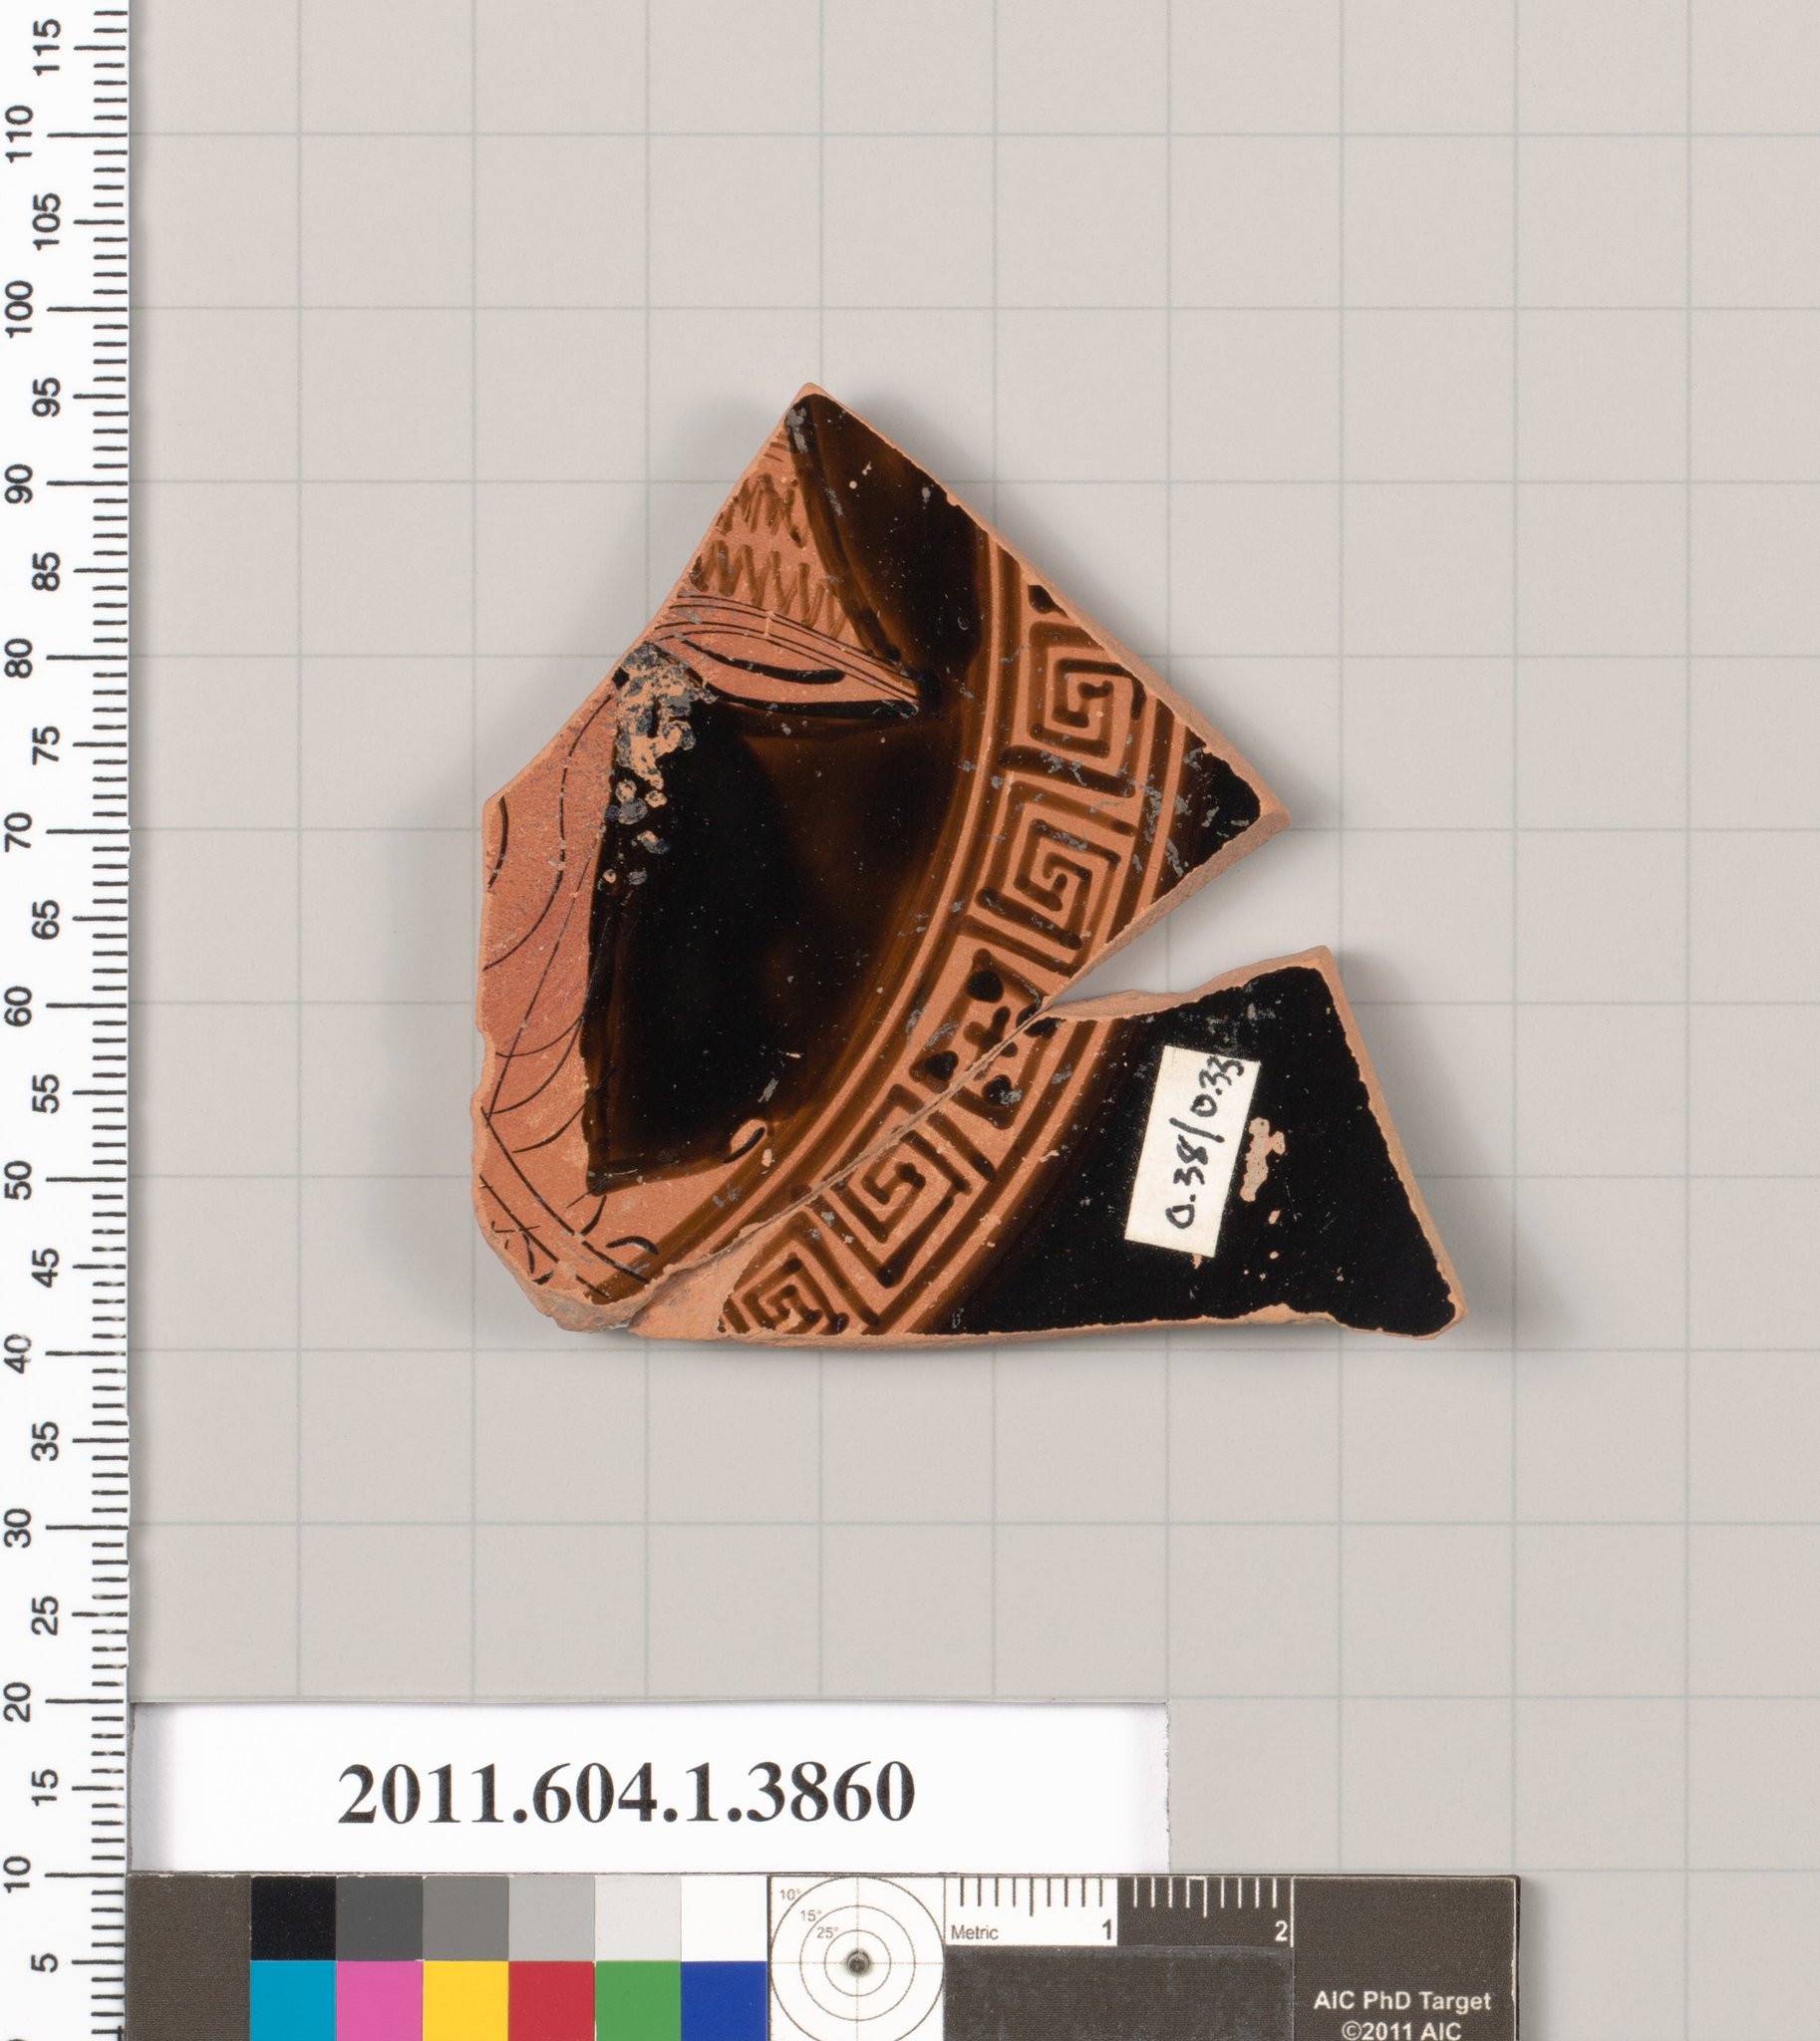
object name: kylix fragment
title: Terracotta fragment of a kylix (drinking cup)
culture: greek, attic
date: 460-450 BCE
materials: terracotta